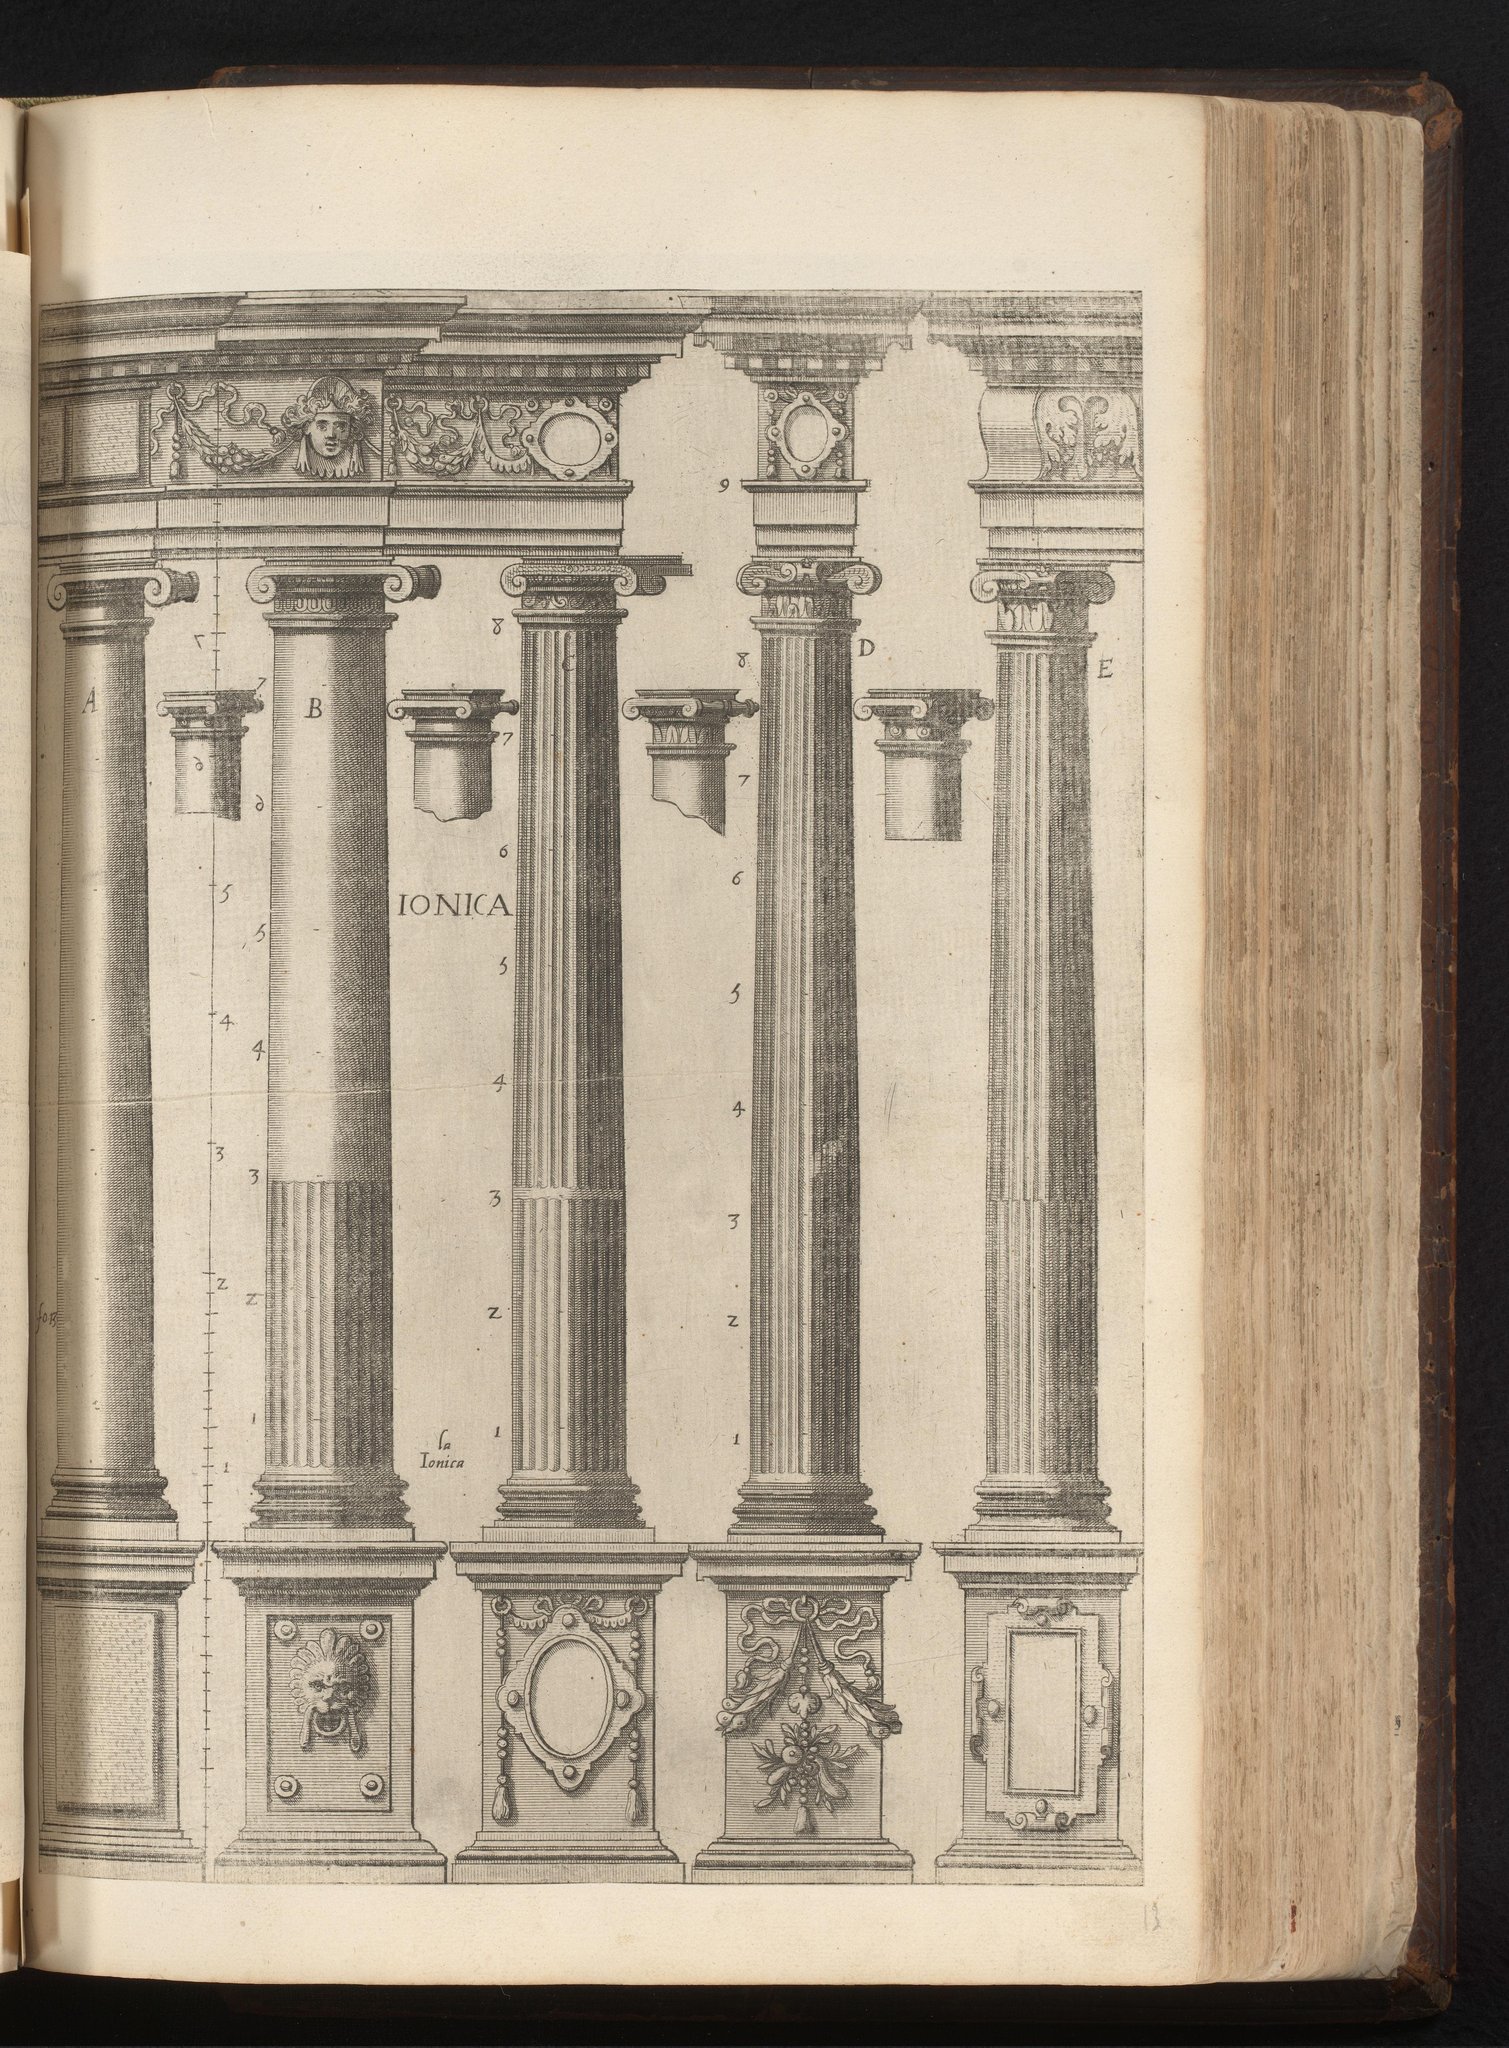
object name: print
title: Ionische zuilen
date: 1581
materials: paper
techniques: engraving, etching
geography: antwerp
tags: ionic order ~ architecture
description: Prent uit: Vredeman de Vries, Hans. Architectura oder Bauung der Antiquen auss dem Vitruvius, waellches sein funff Collummen orden, (...). Antwerpen: Gerard de Jode en Gerard Smits, 1581. Prent eerder verschenen in de 1577-editie.